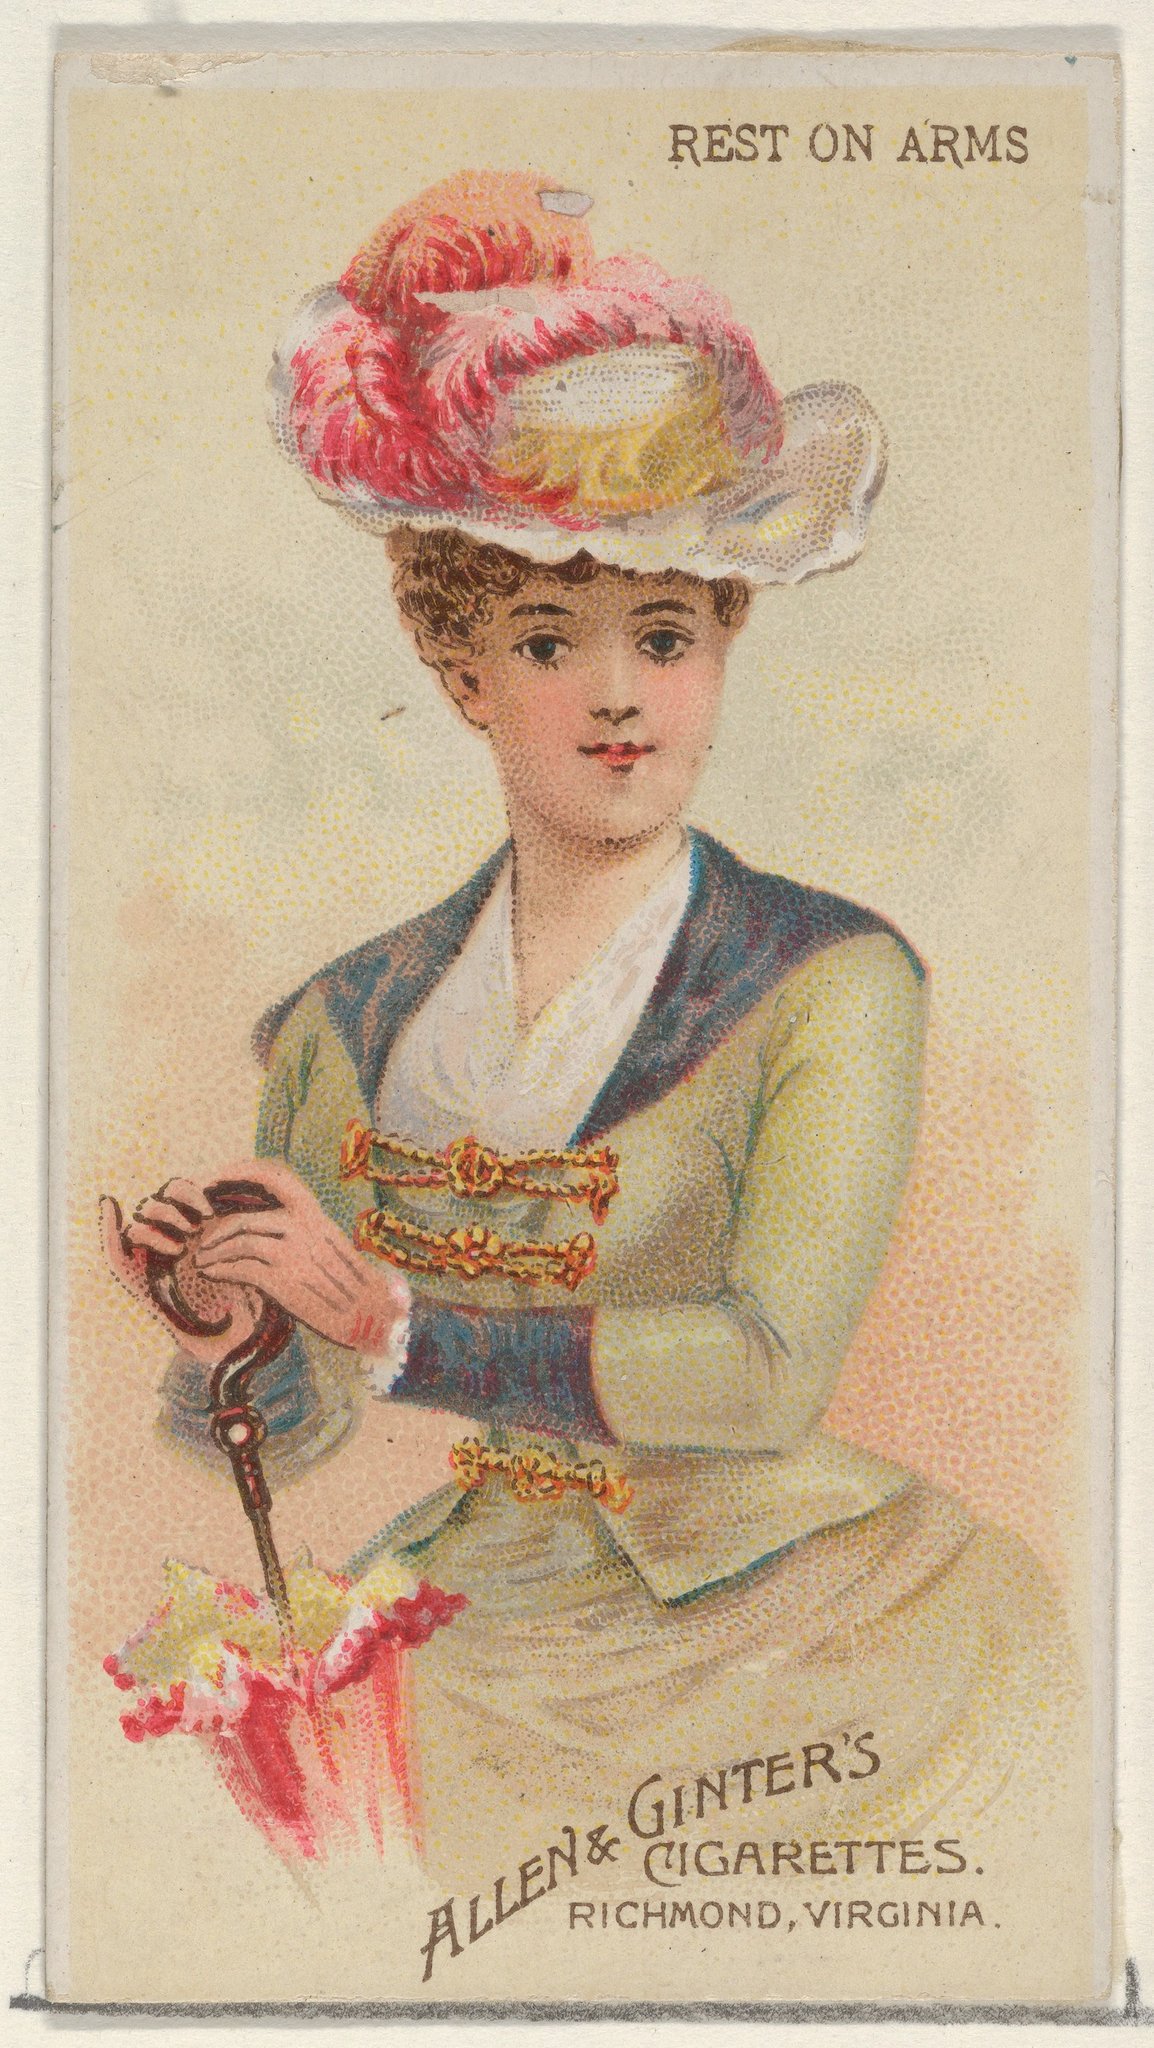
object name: print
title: Rest on Arms, from the Parasol Drills series (N18) for Allen & Ginter Cigarettes Brands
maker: allen & ginter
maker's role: publisher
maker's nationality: american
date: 1888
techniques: color lithograph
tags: women